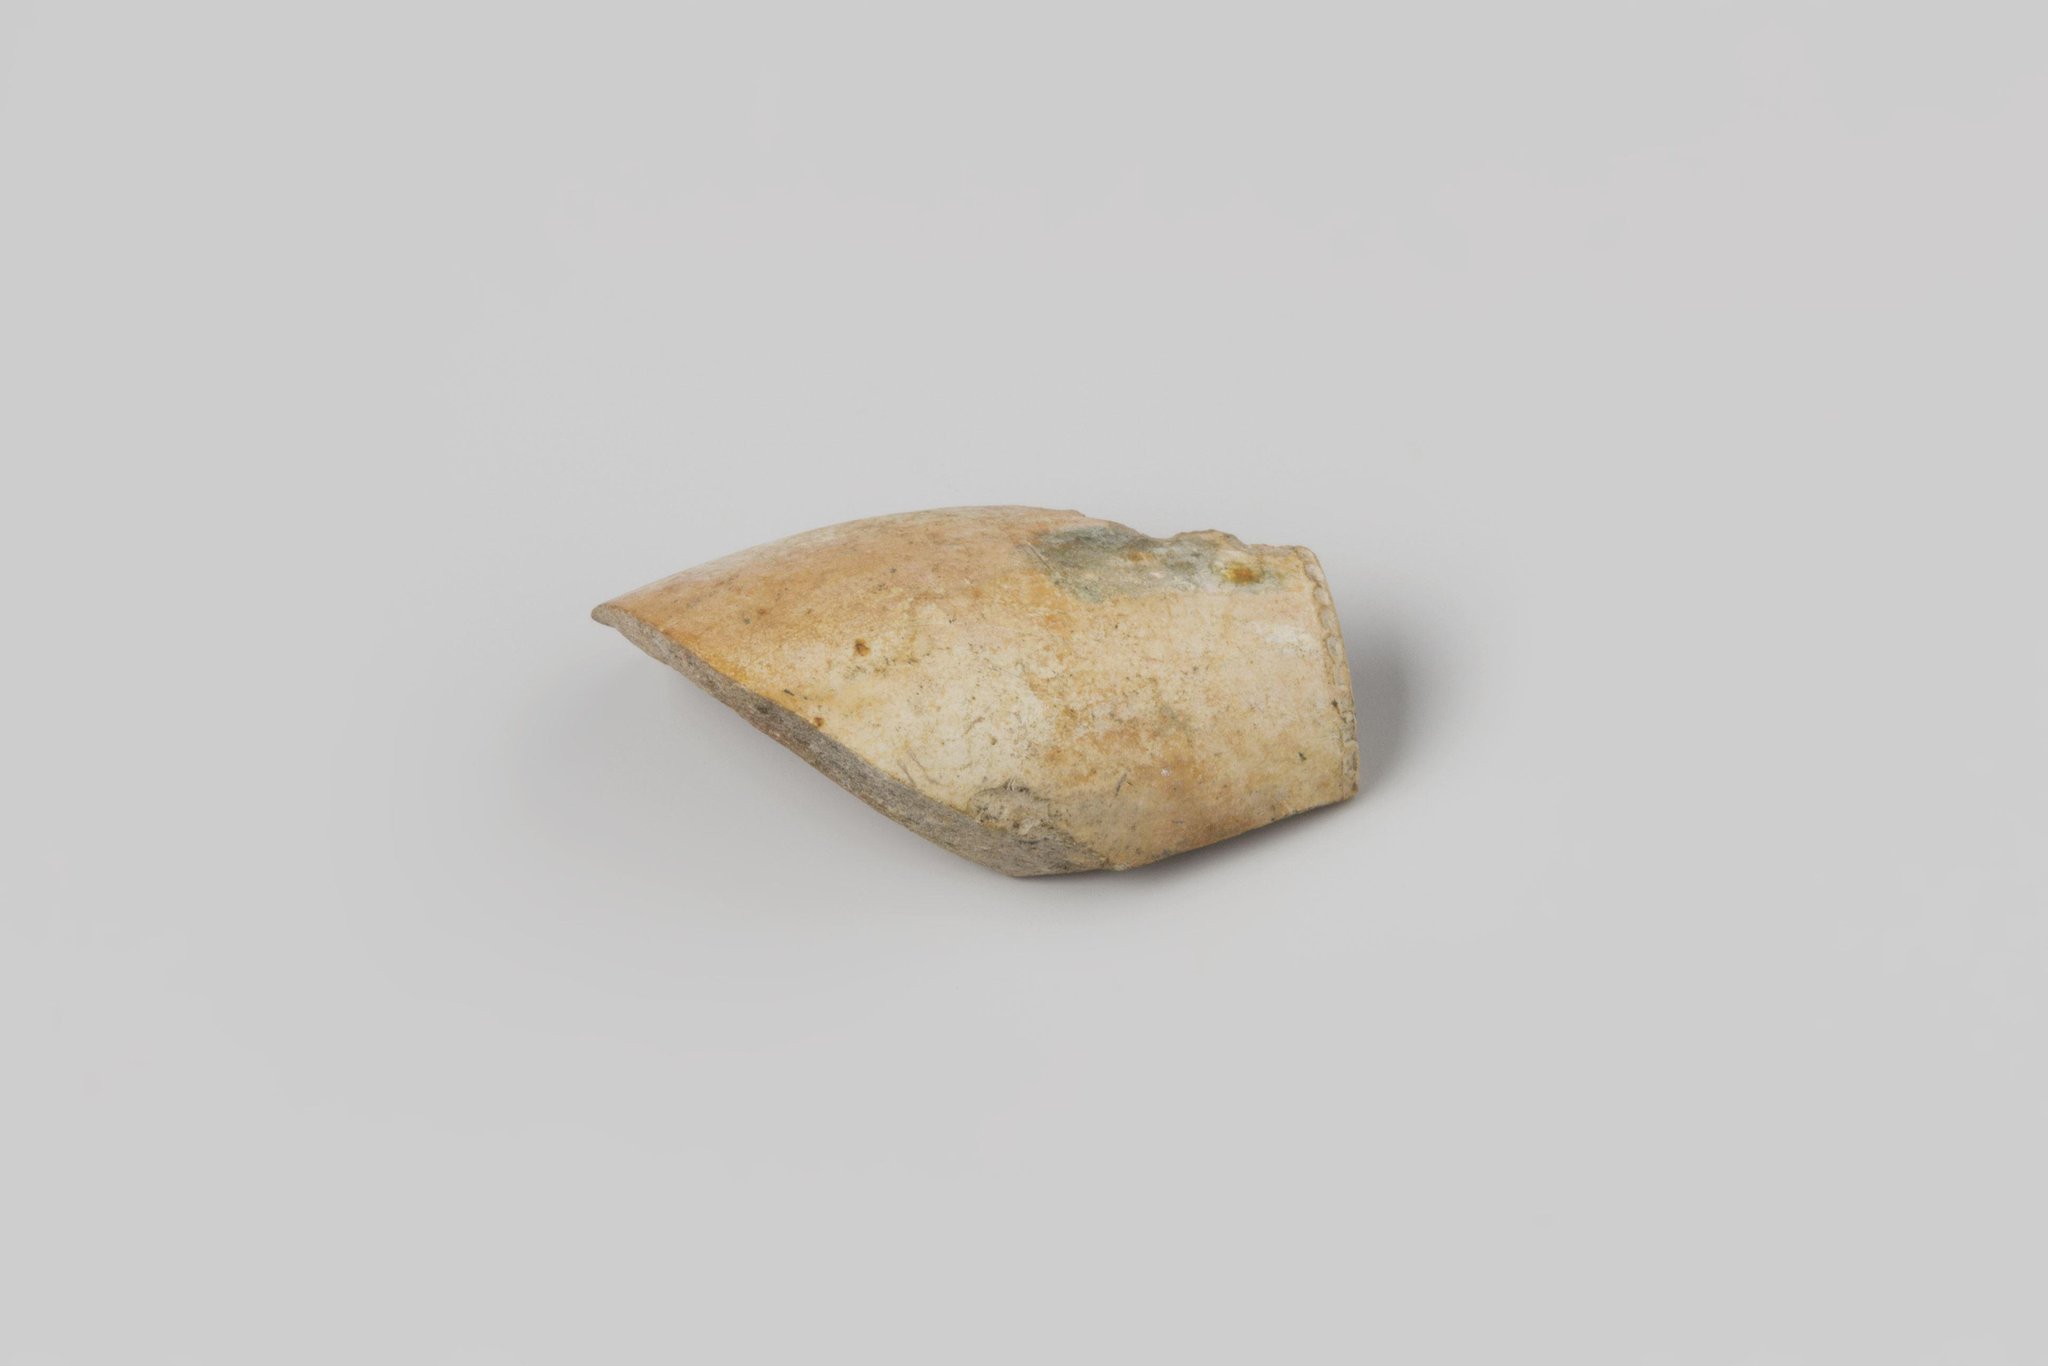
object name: pipe bowl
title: Fragment pijpenkop uit het wrak van de Oost-Indiëvaarder Hollandia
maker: Anonymous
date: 1700-1743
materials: clay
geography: netherlands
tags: verenigde oostindische compagnie, hollandia (schip), annet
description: Pipe, bowl, heelmark illegible; fragment.